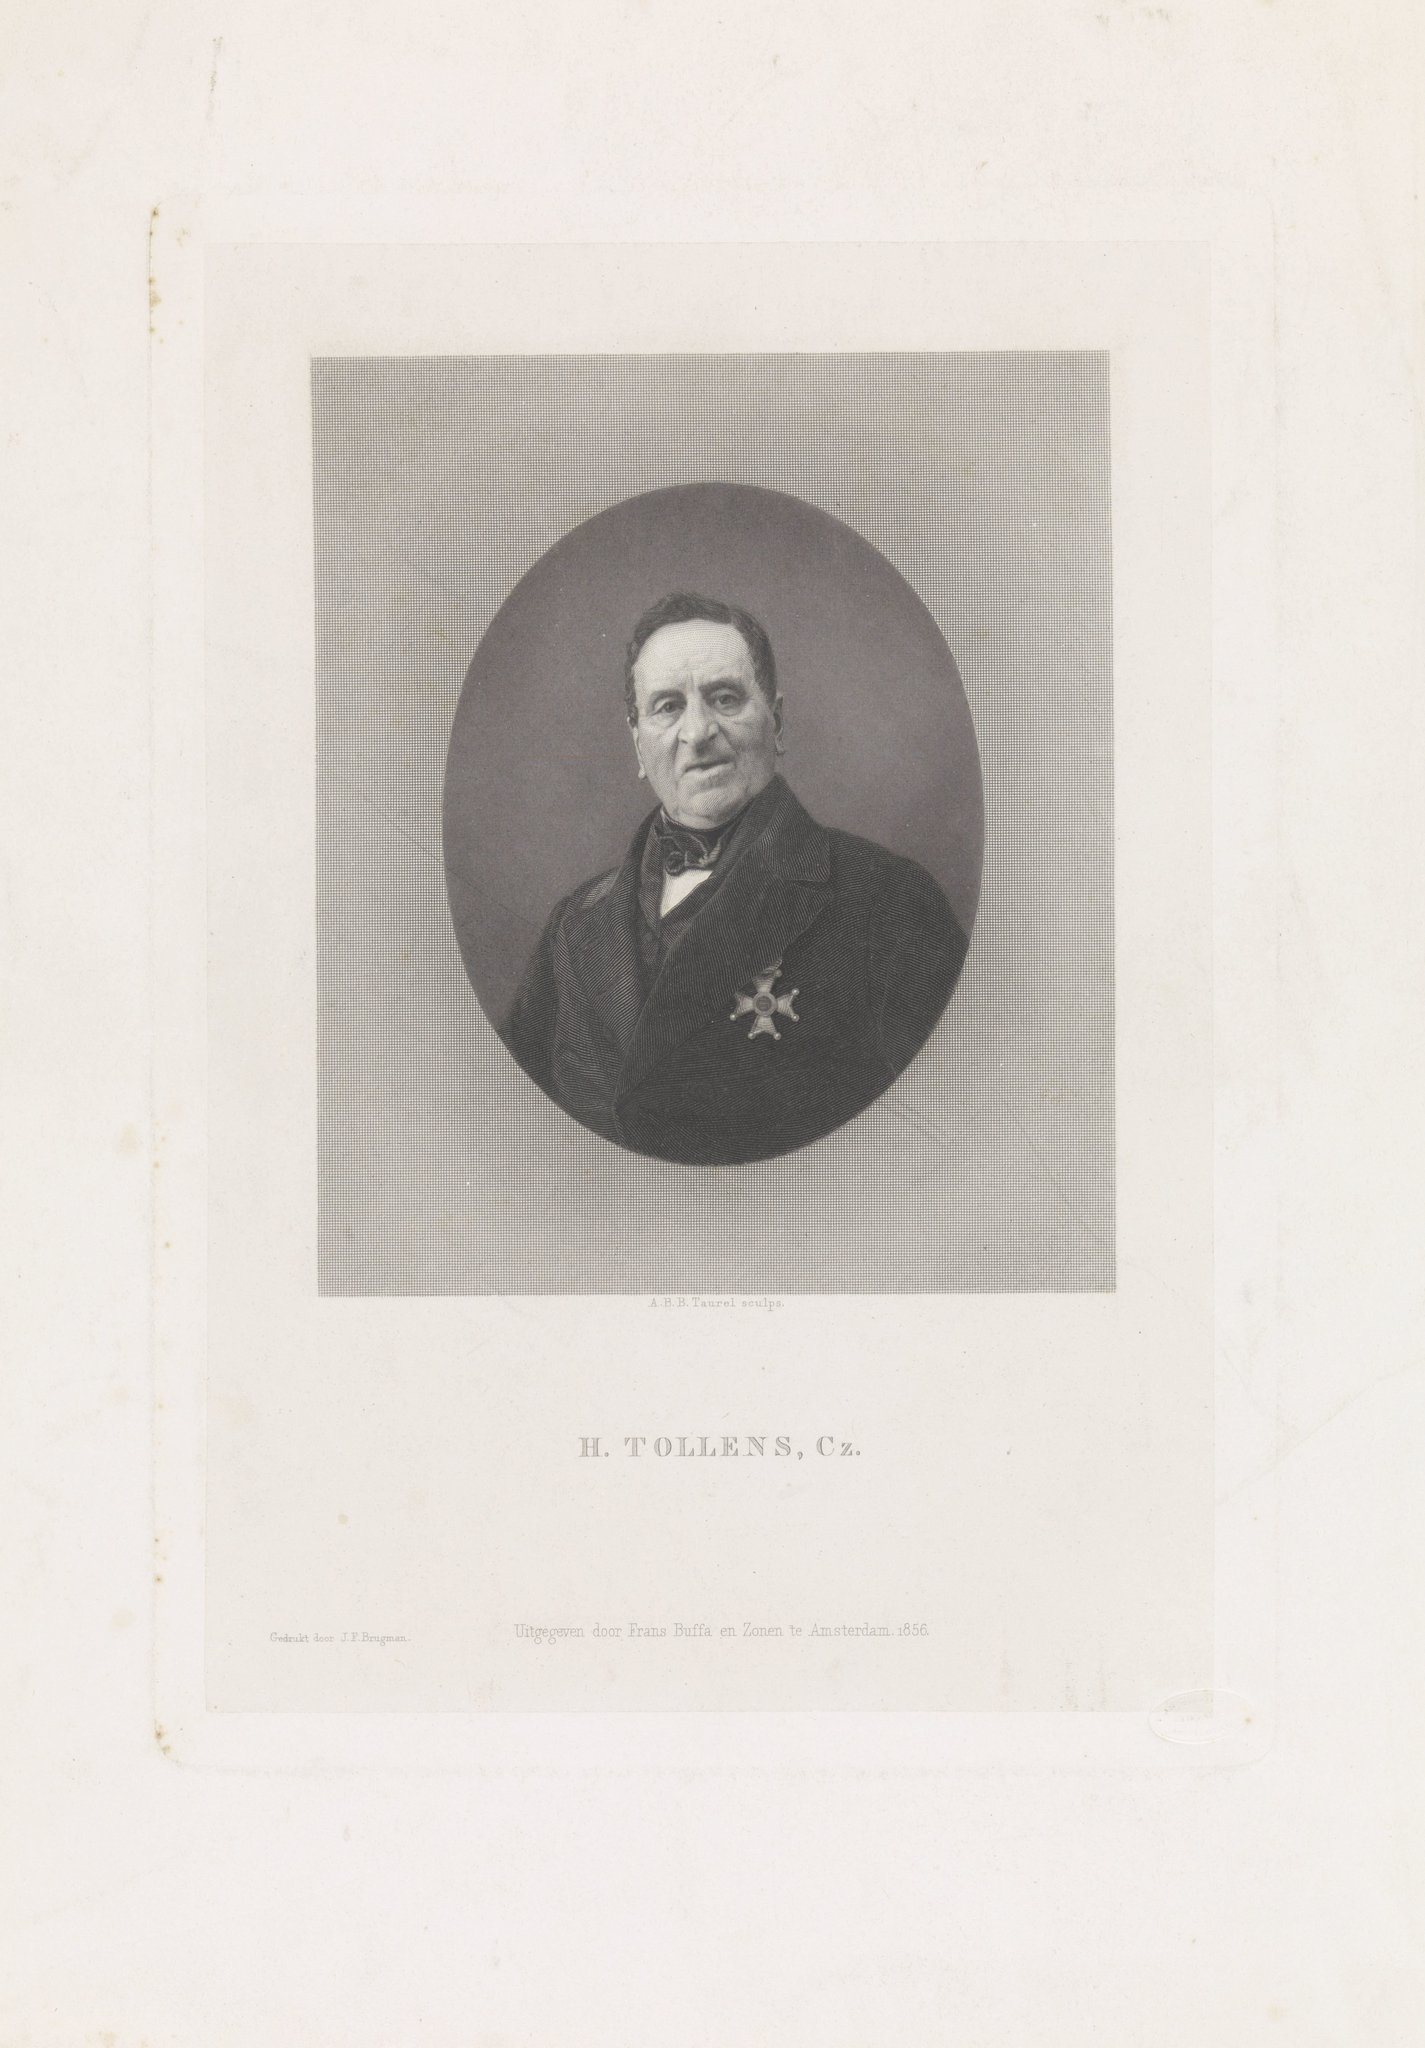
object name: print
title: Portret van de Rotterdamse dichter en koopman Hendrik Tollens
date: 1856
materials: paper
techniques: engraving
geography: amsterdam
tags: rotterdam, hendrik tollens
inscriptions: check stamp: ‘Frans Buffa en Zonen uitgevers Amsterdam’, collector's mark: Lugt 2228